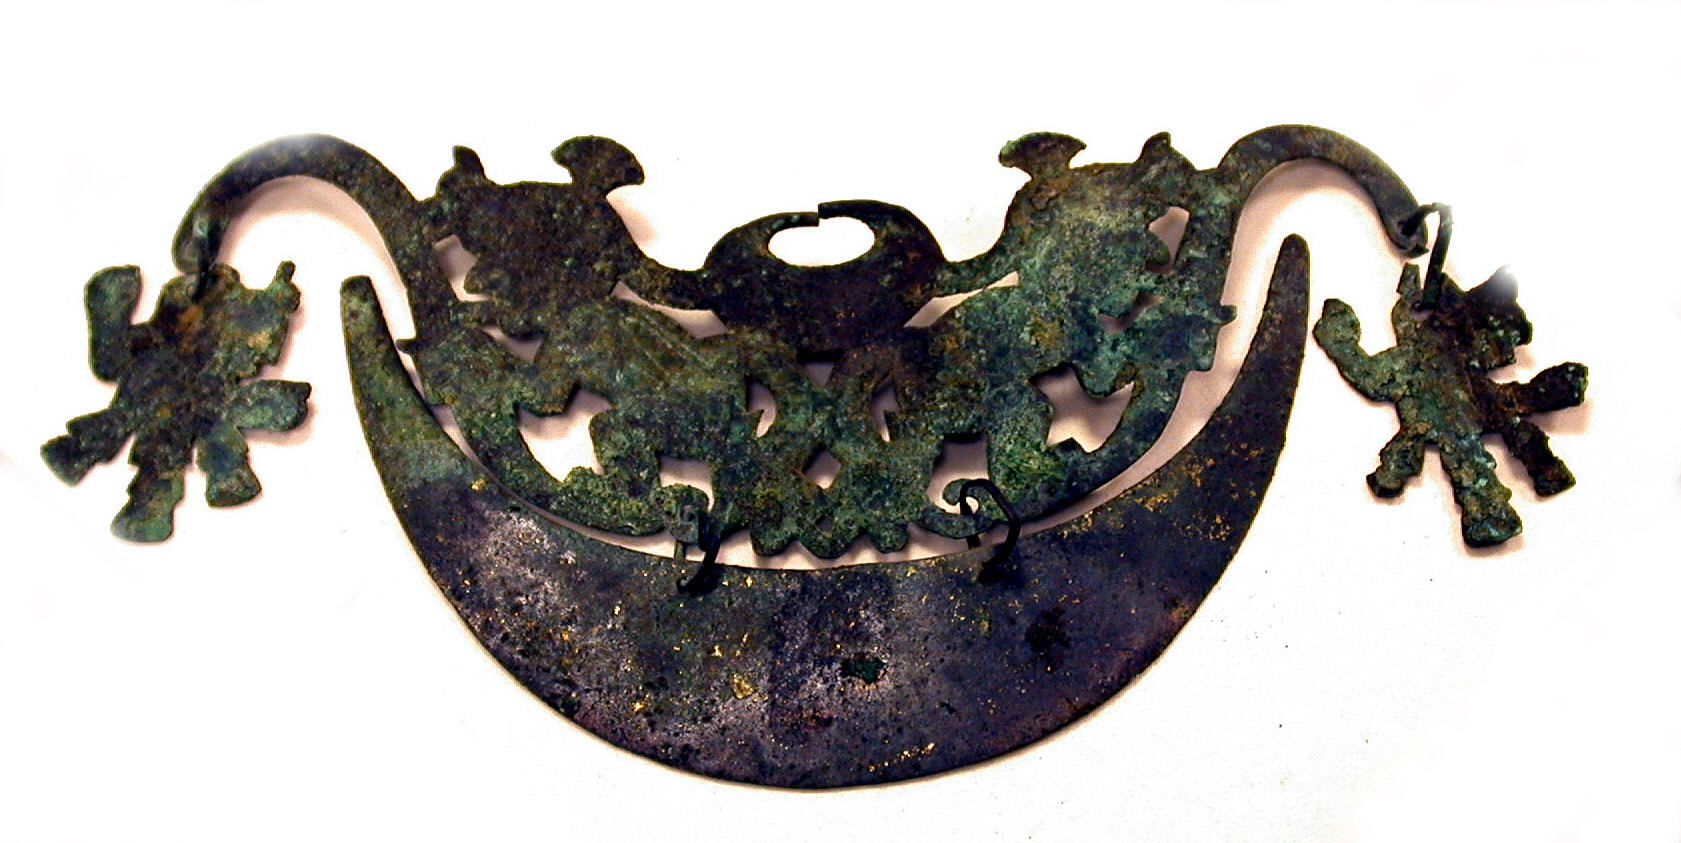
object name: nose ornament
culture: moche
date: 501-700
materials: gilt copper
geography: peru